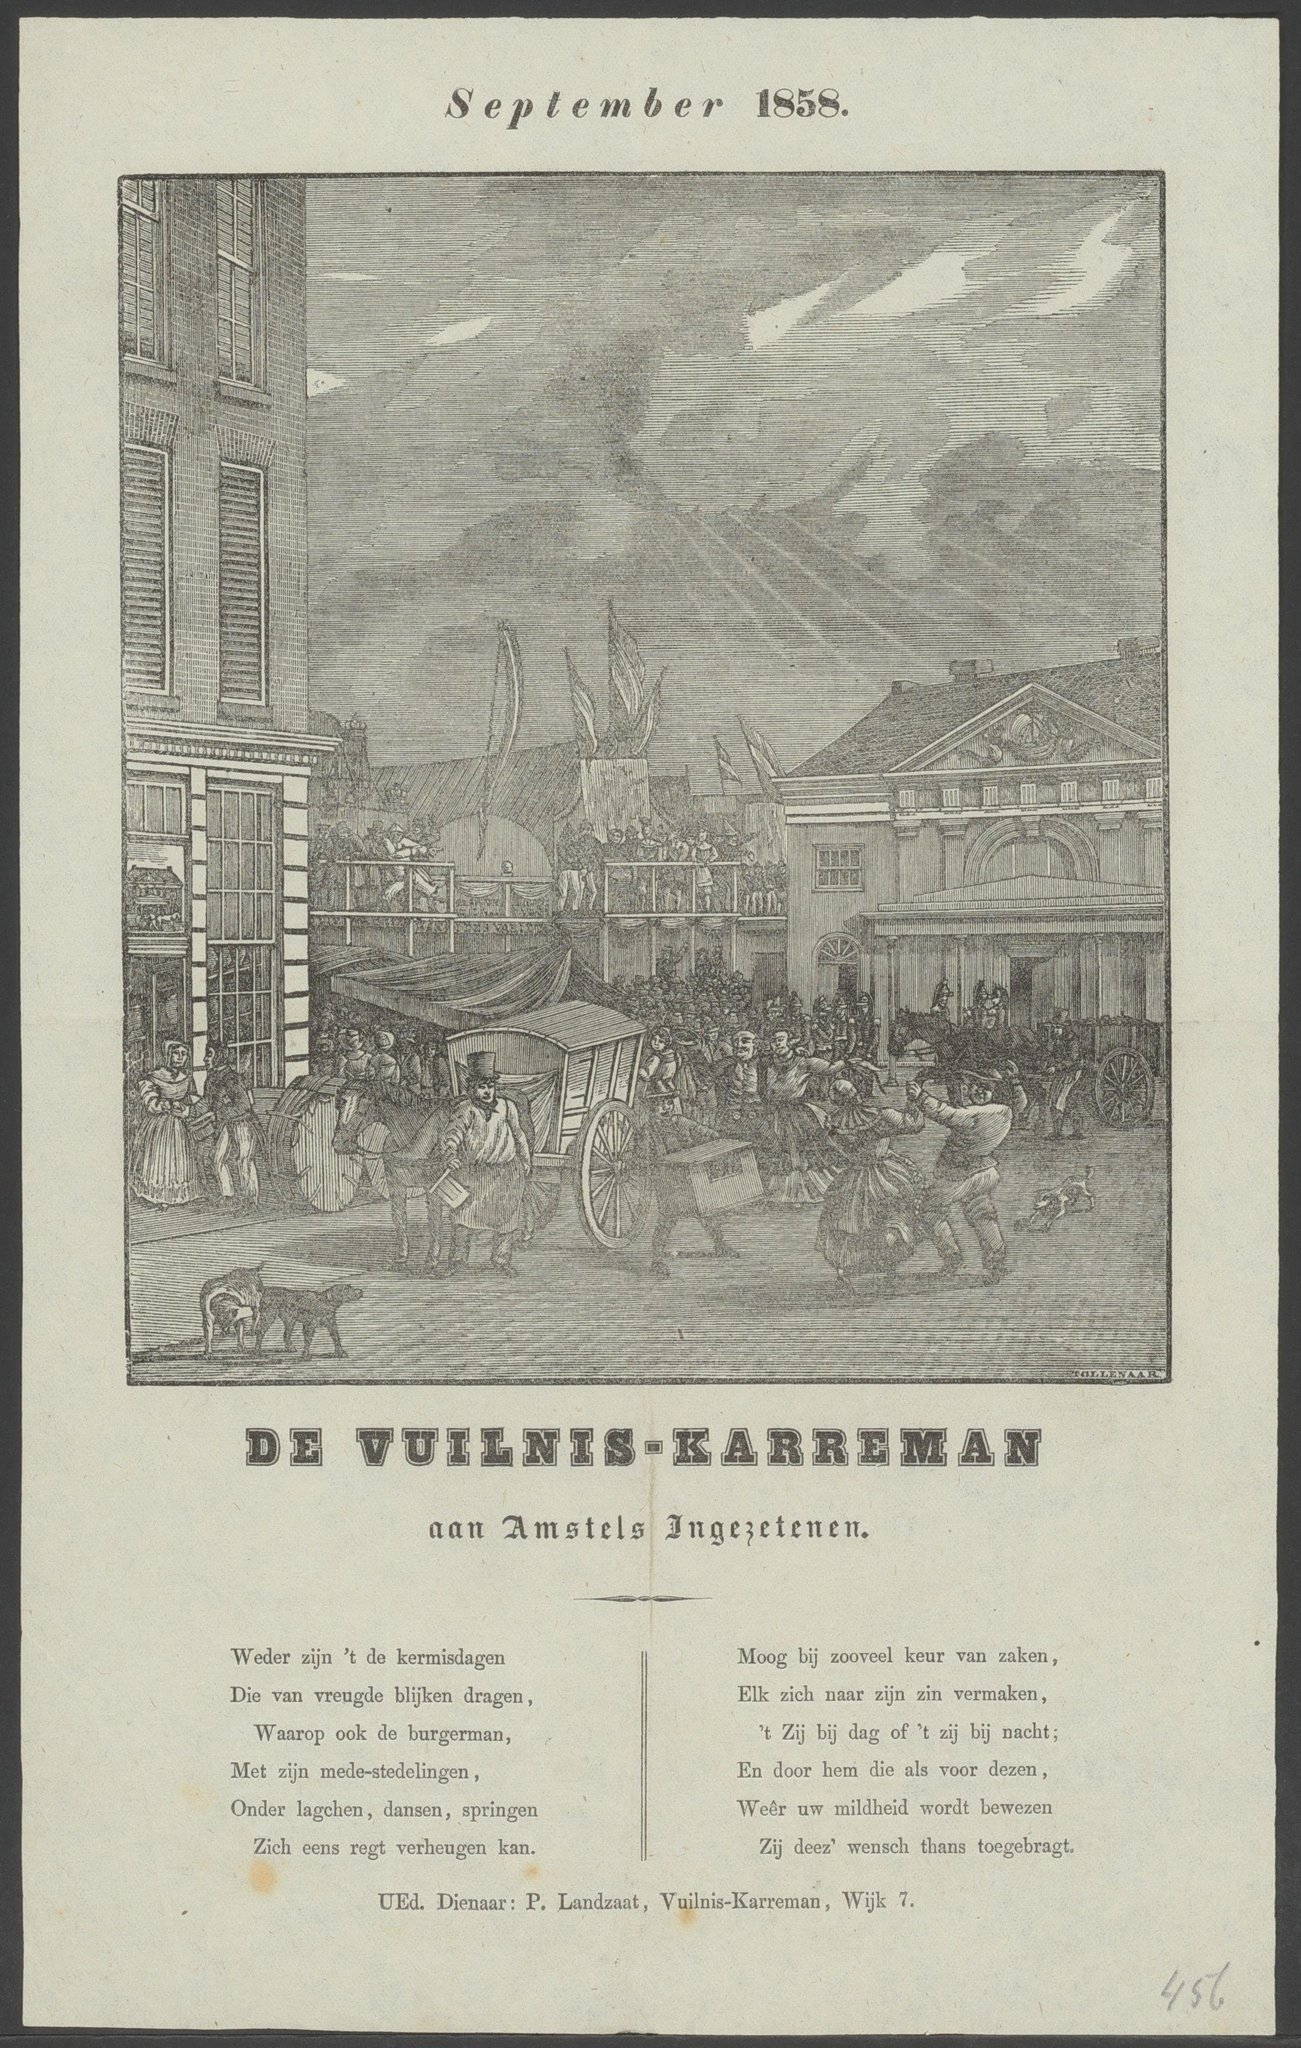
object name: fair print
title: Kermisprent van de vuilnismannen van Amsterdam voor het jaar 1858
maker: dirk wijbrand tollenaar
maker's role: print maker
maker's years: 1808-1858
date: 1858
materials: paper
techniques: letterpress printing, engraving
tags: street, garbage collection, amsterdam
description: Kermisprent van de Amsterdamse vuilnismannen voor het jaar 1858. Gezicht op de kermis op de Botermarkt met de oude Waag. Op de markt twee vuilniskarren. Met gedicht in twee kolommen. Van de vuilniskarman in de wijk no. 7: P. Landzaat. Onderwerpsrubrieken binnen de Atlas Zeden en Gewoonten: Zeden en gewoonten in engeren zin, Volksleven, Volksbladen, Nieuwjaars- en Kerstwenschen, Amsterdam.